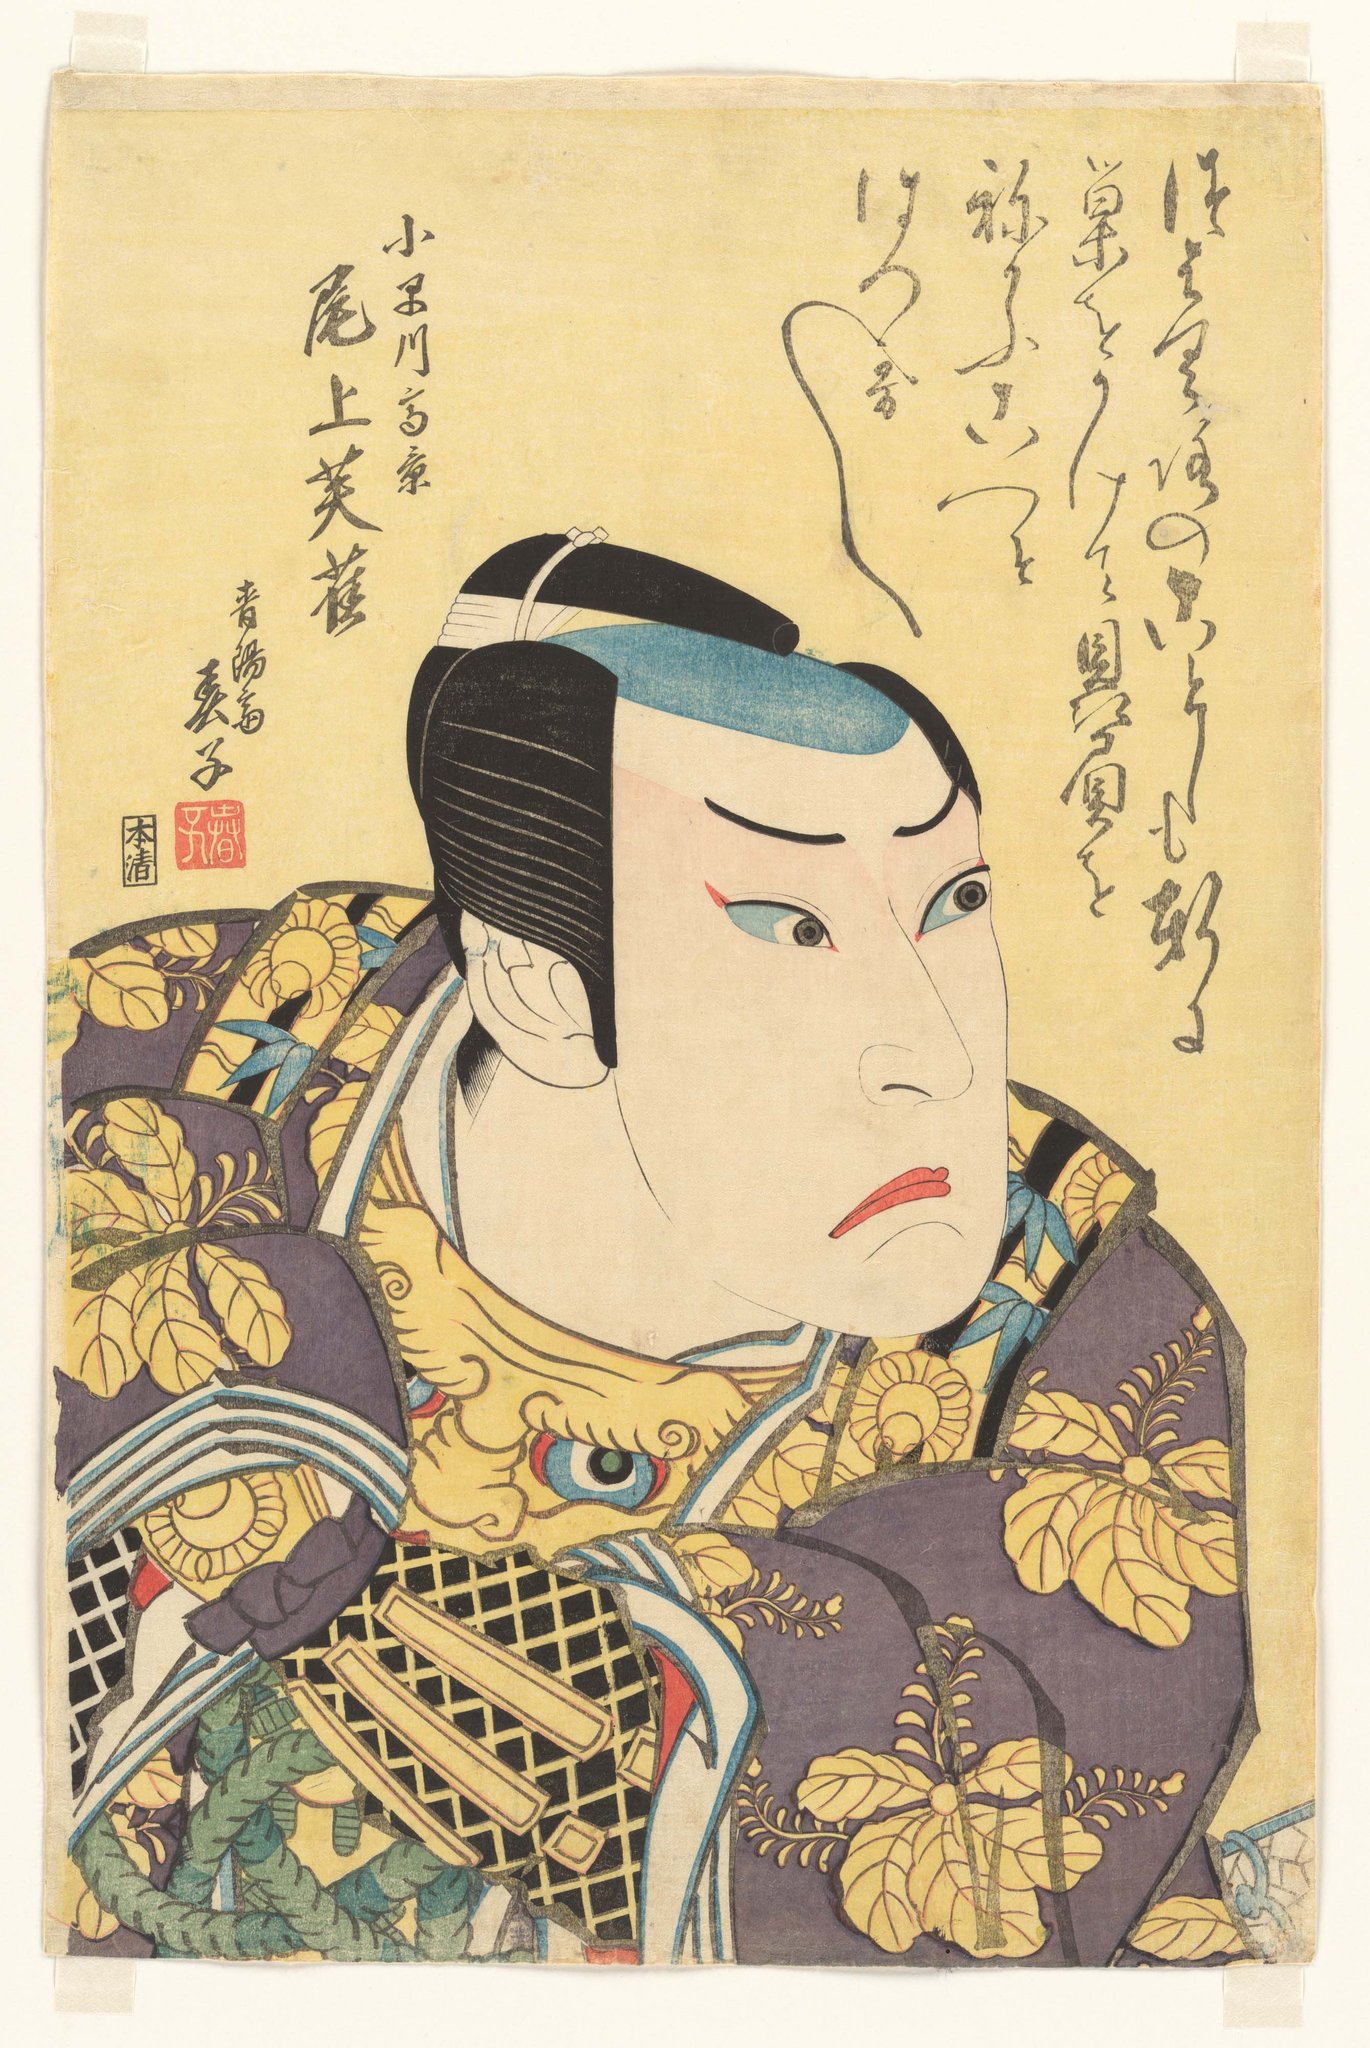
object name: woodblock print nishiki e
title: The Actor Onoe Fujaku III as Kobayakawa Takakage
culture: japanese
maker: seiyōsai shunshi 青陽斎春子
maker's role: artist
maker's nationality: japanese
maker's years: 1820-1829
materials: ink, paper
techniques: nishiki e, woodblock print